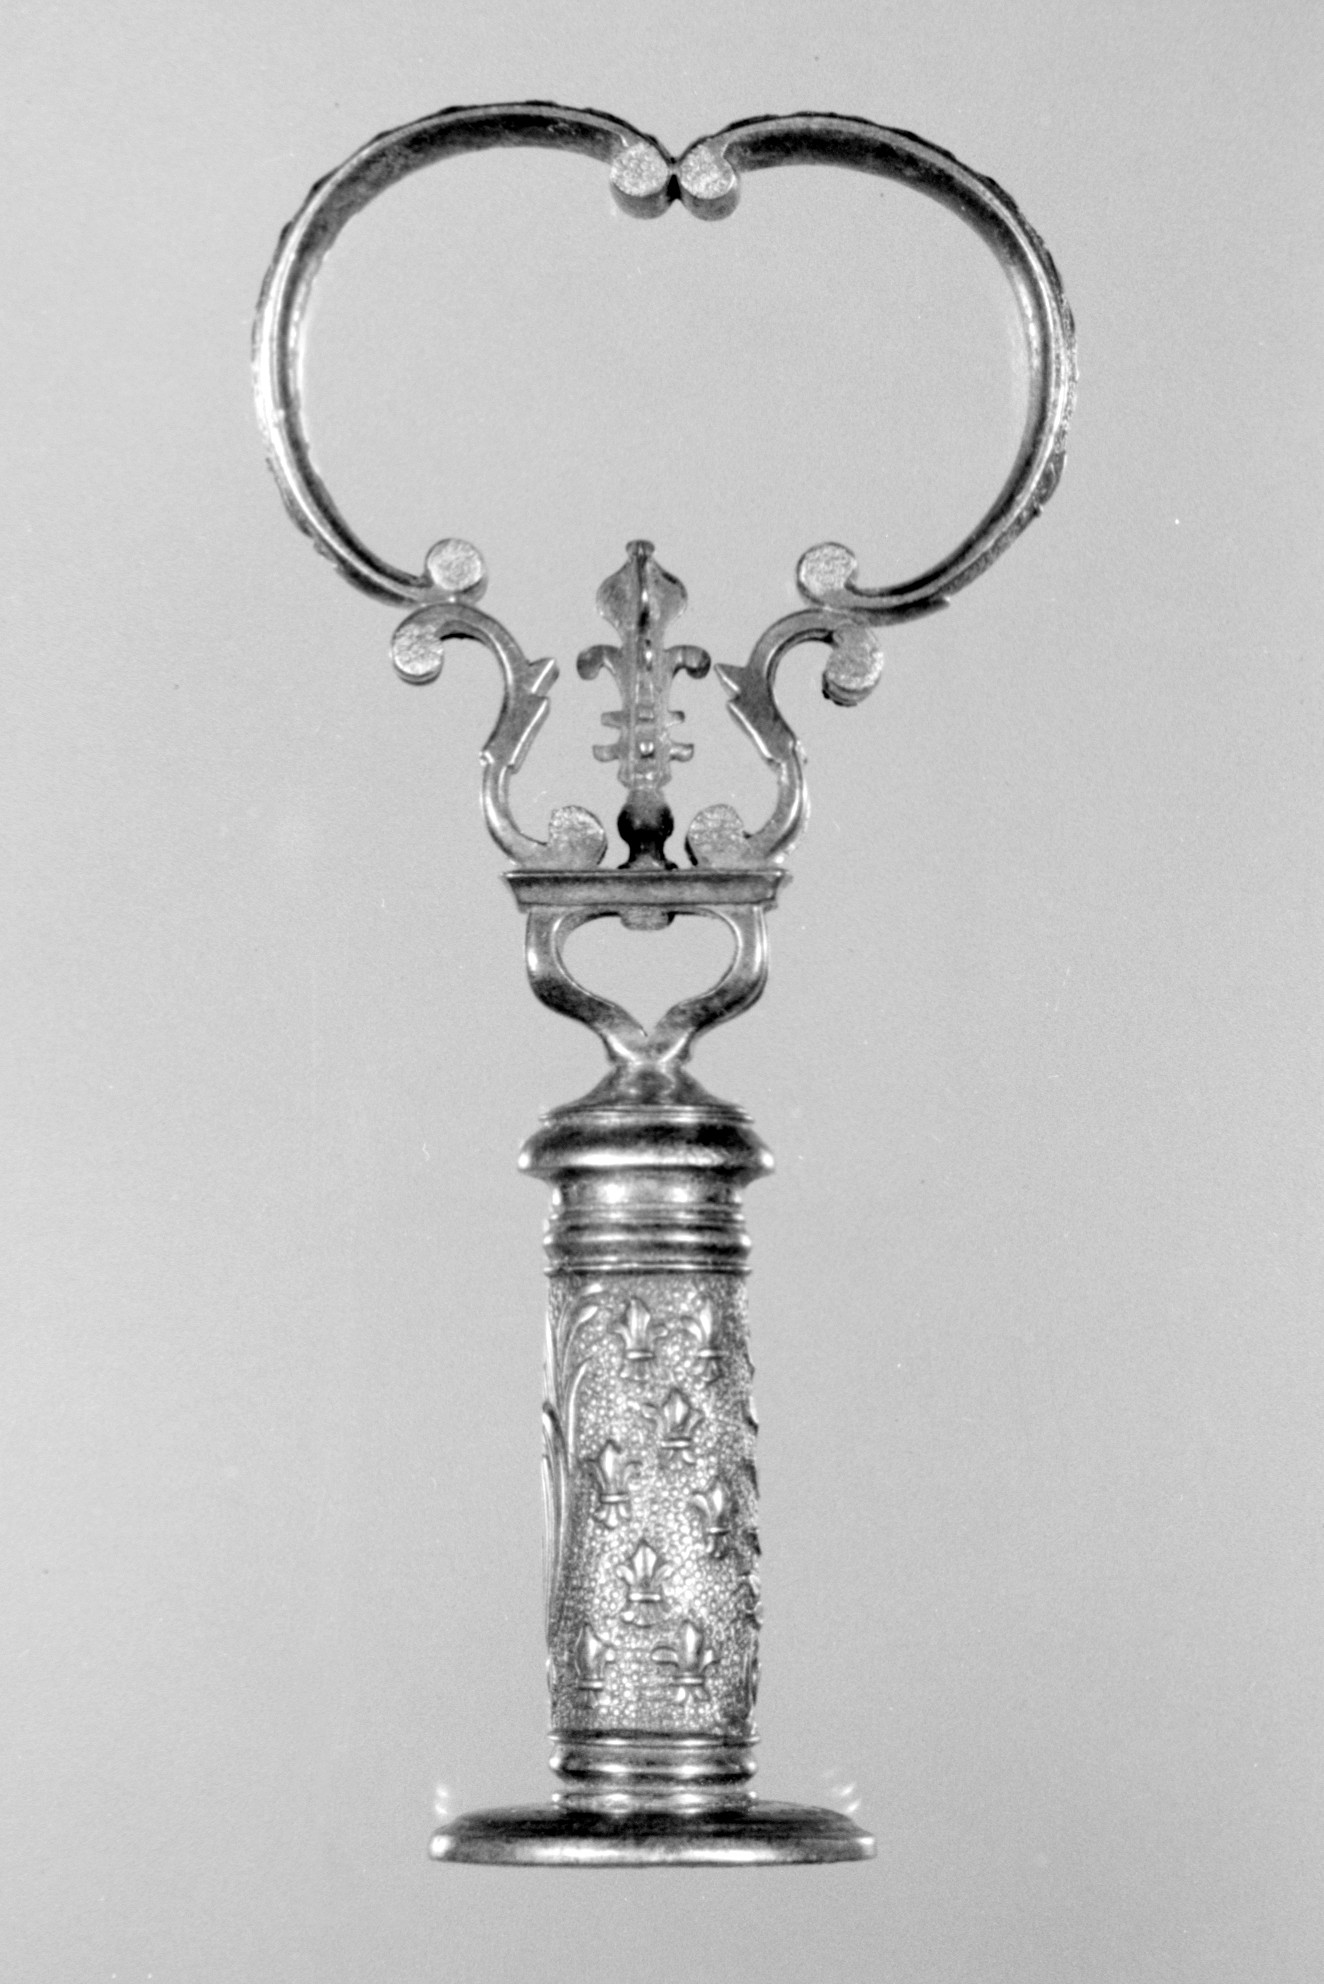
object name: seal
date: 1701-1800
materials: steel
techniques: gilding